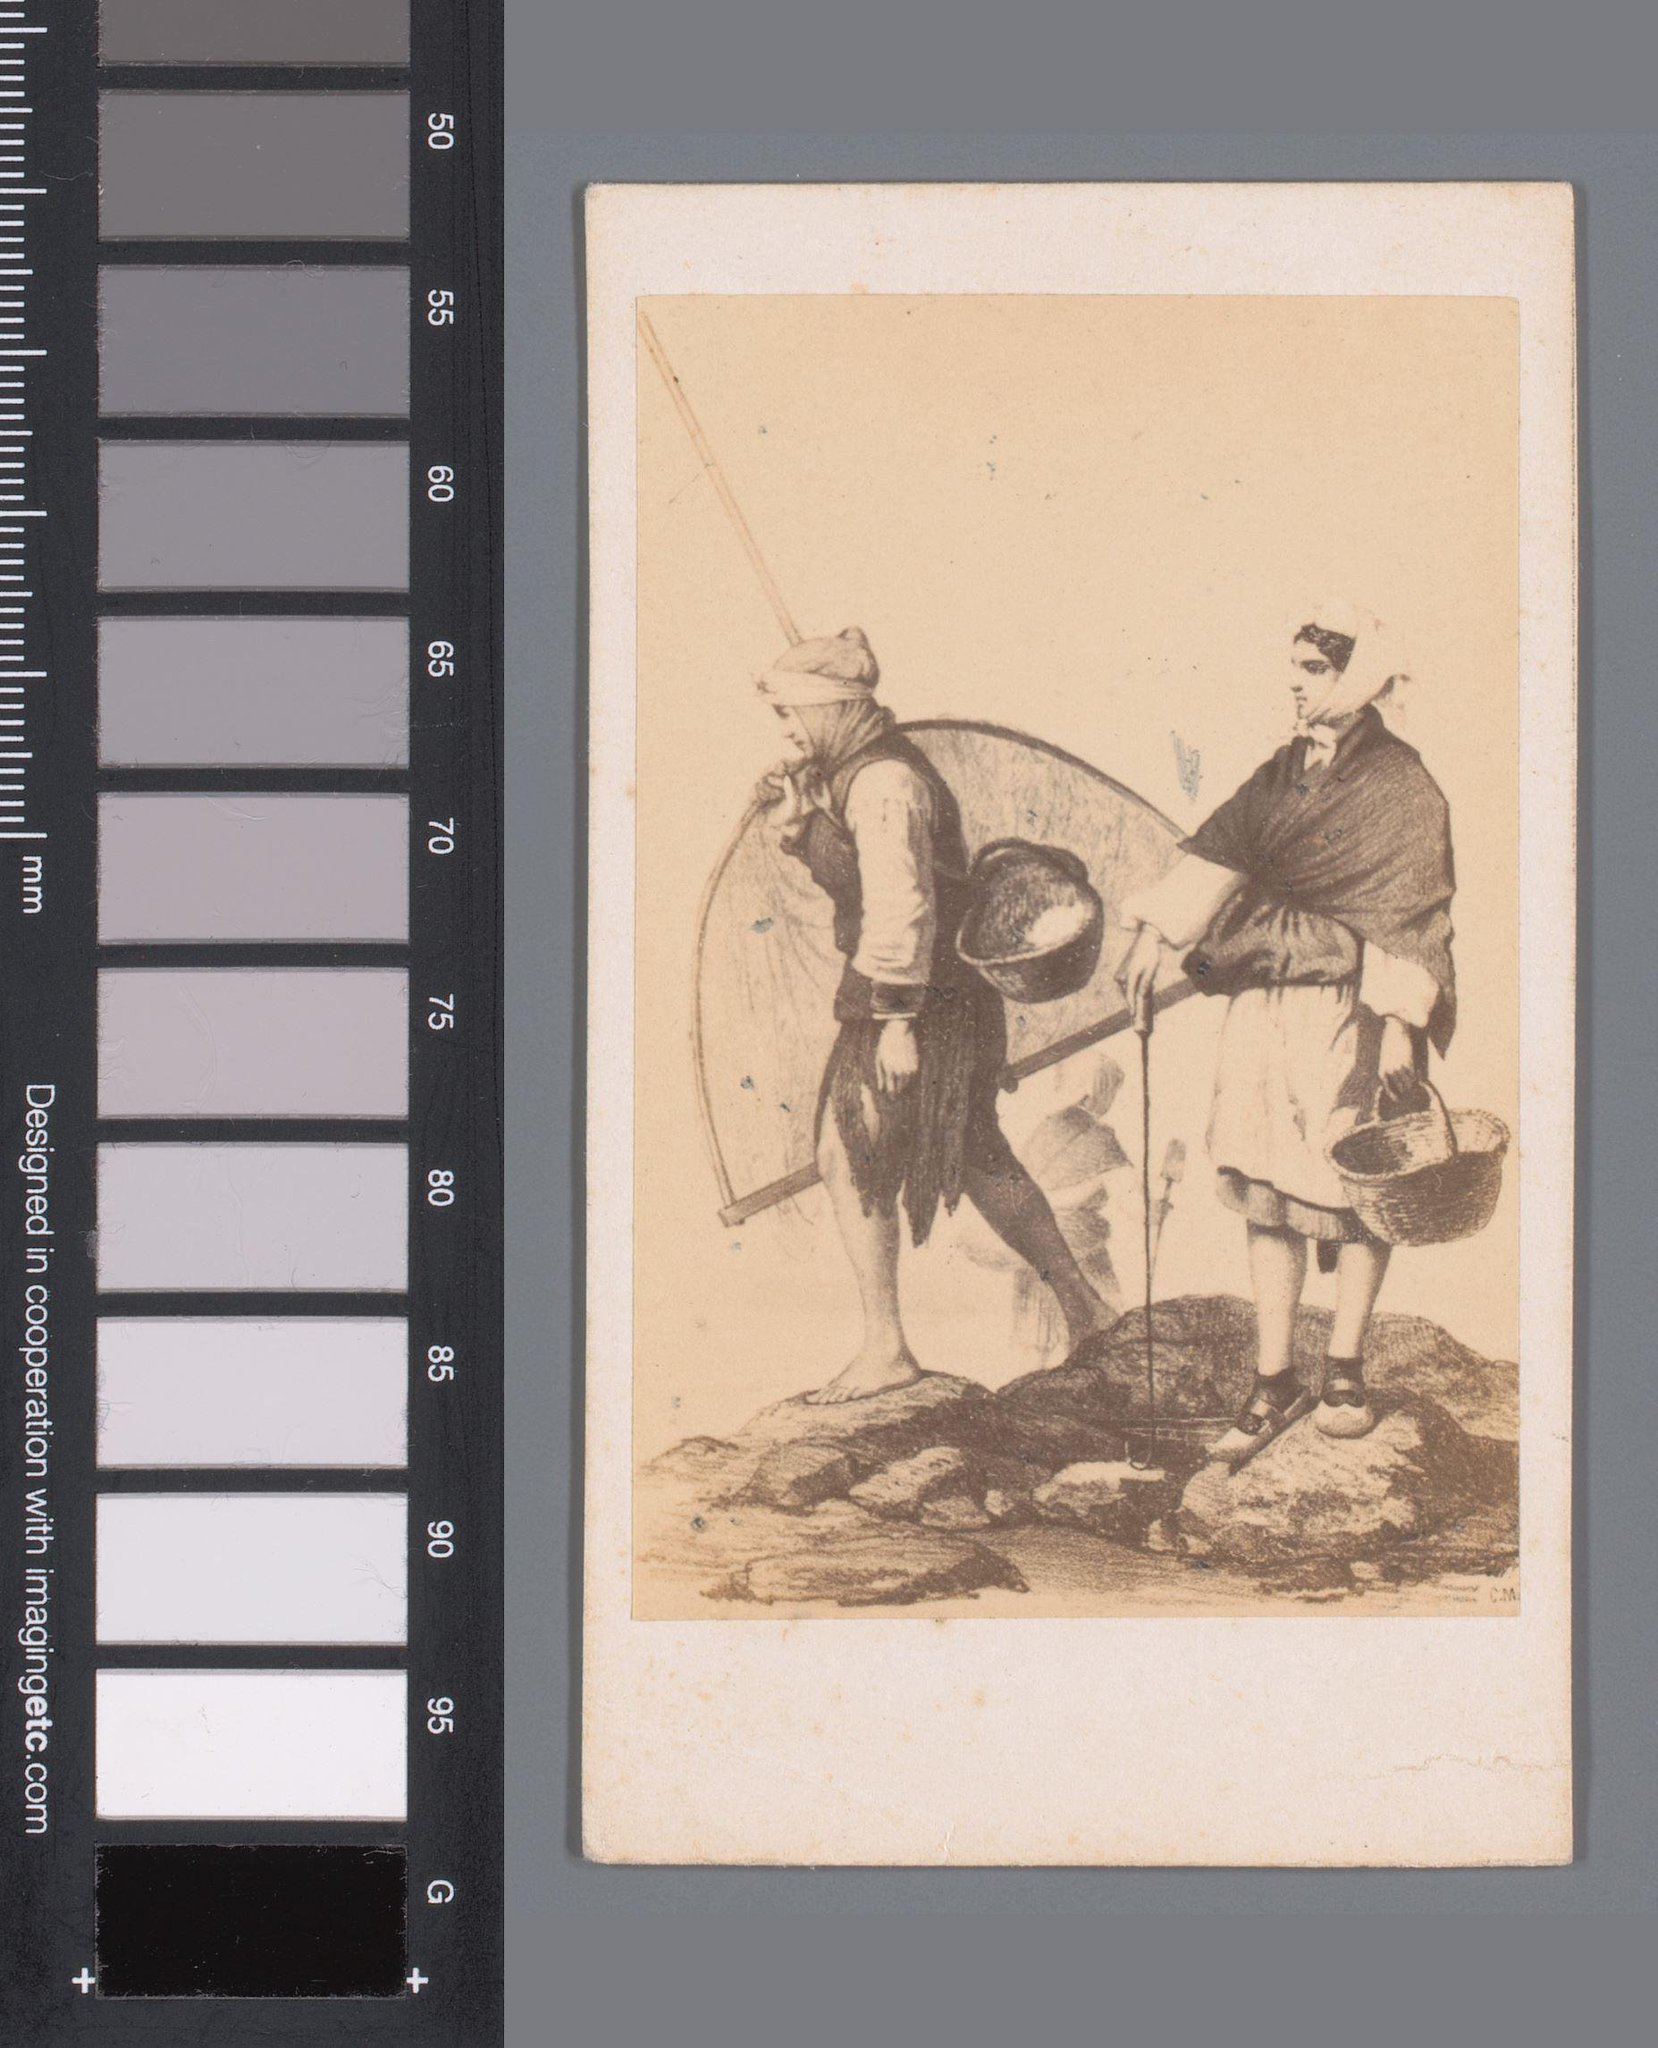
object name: carte de visite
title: Fotoreproductie van een tekening van vissers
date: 1856-1869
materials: cardboard, paper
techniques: albumen print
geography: paris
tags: fisherman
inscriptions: address: ‘Rue St. André des Arts, 52,/ PARIS./ 3. Rue Racine, Paris.’, inscription: ‘Granvillaines’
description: Mogelijk beeldt de tekening Granvillais uit, vissers uit het Franse Granville.